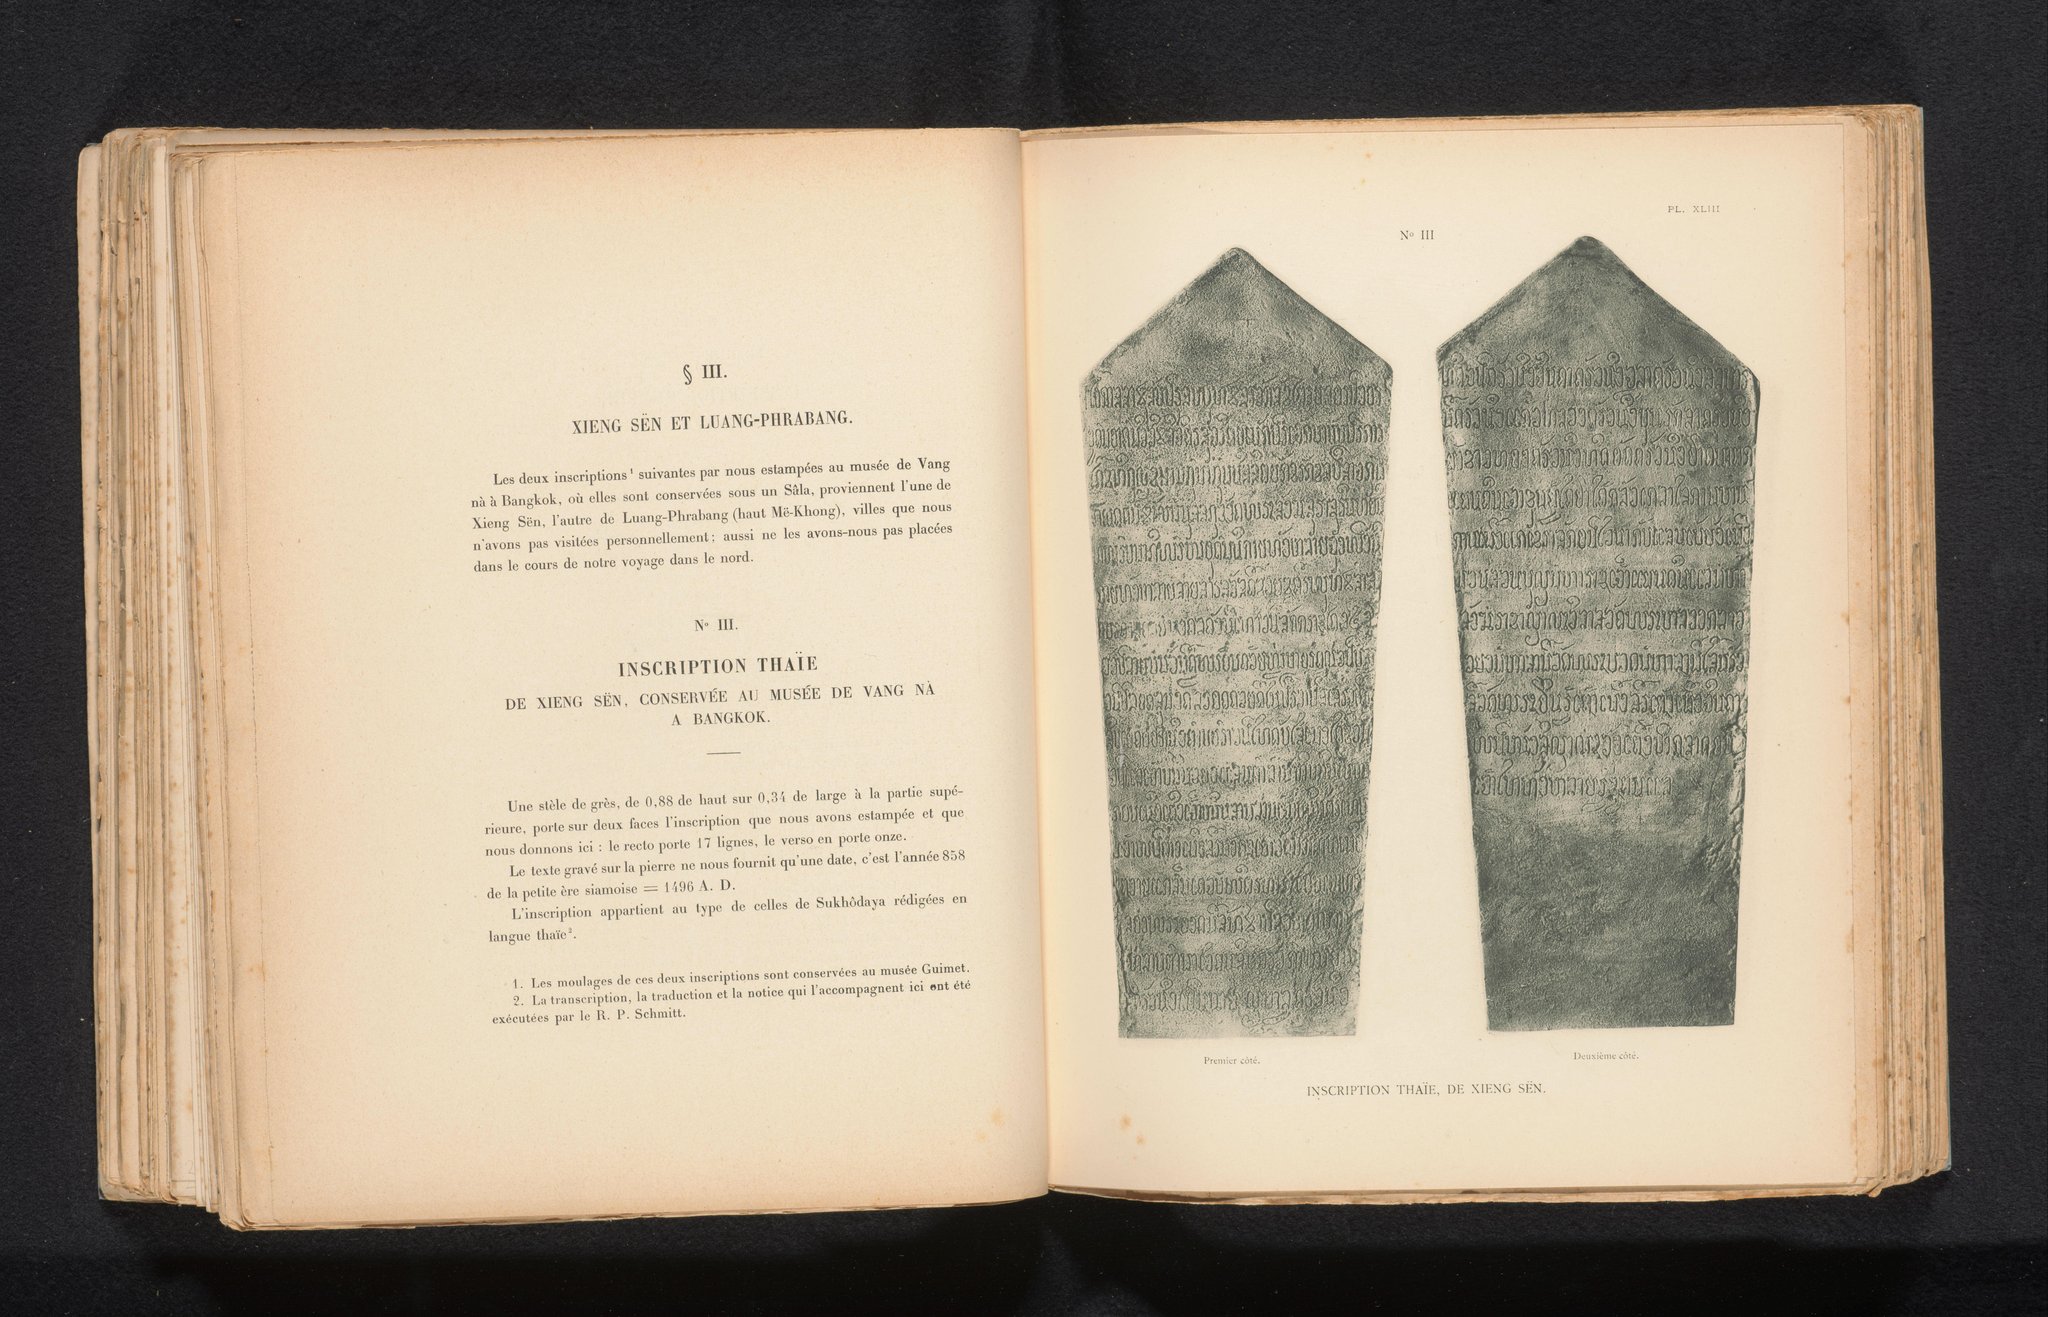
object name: page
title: Voor- en achterzijde van een stèle met een inscriptie in het Thai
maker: Anonymous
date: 1890-1895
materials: paper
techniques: photograph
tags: inscription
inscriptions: inscription: ‘No. III/ Premier côté. Deuxième côte.’, collector's mark: ‘Société d'Emulation de l'Ain/ Bourg/ Bibliothèque’, inscription: ‘Pl. XLIII’